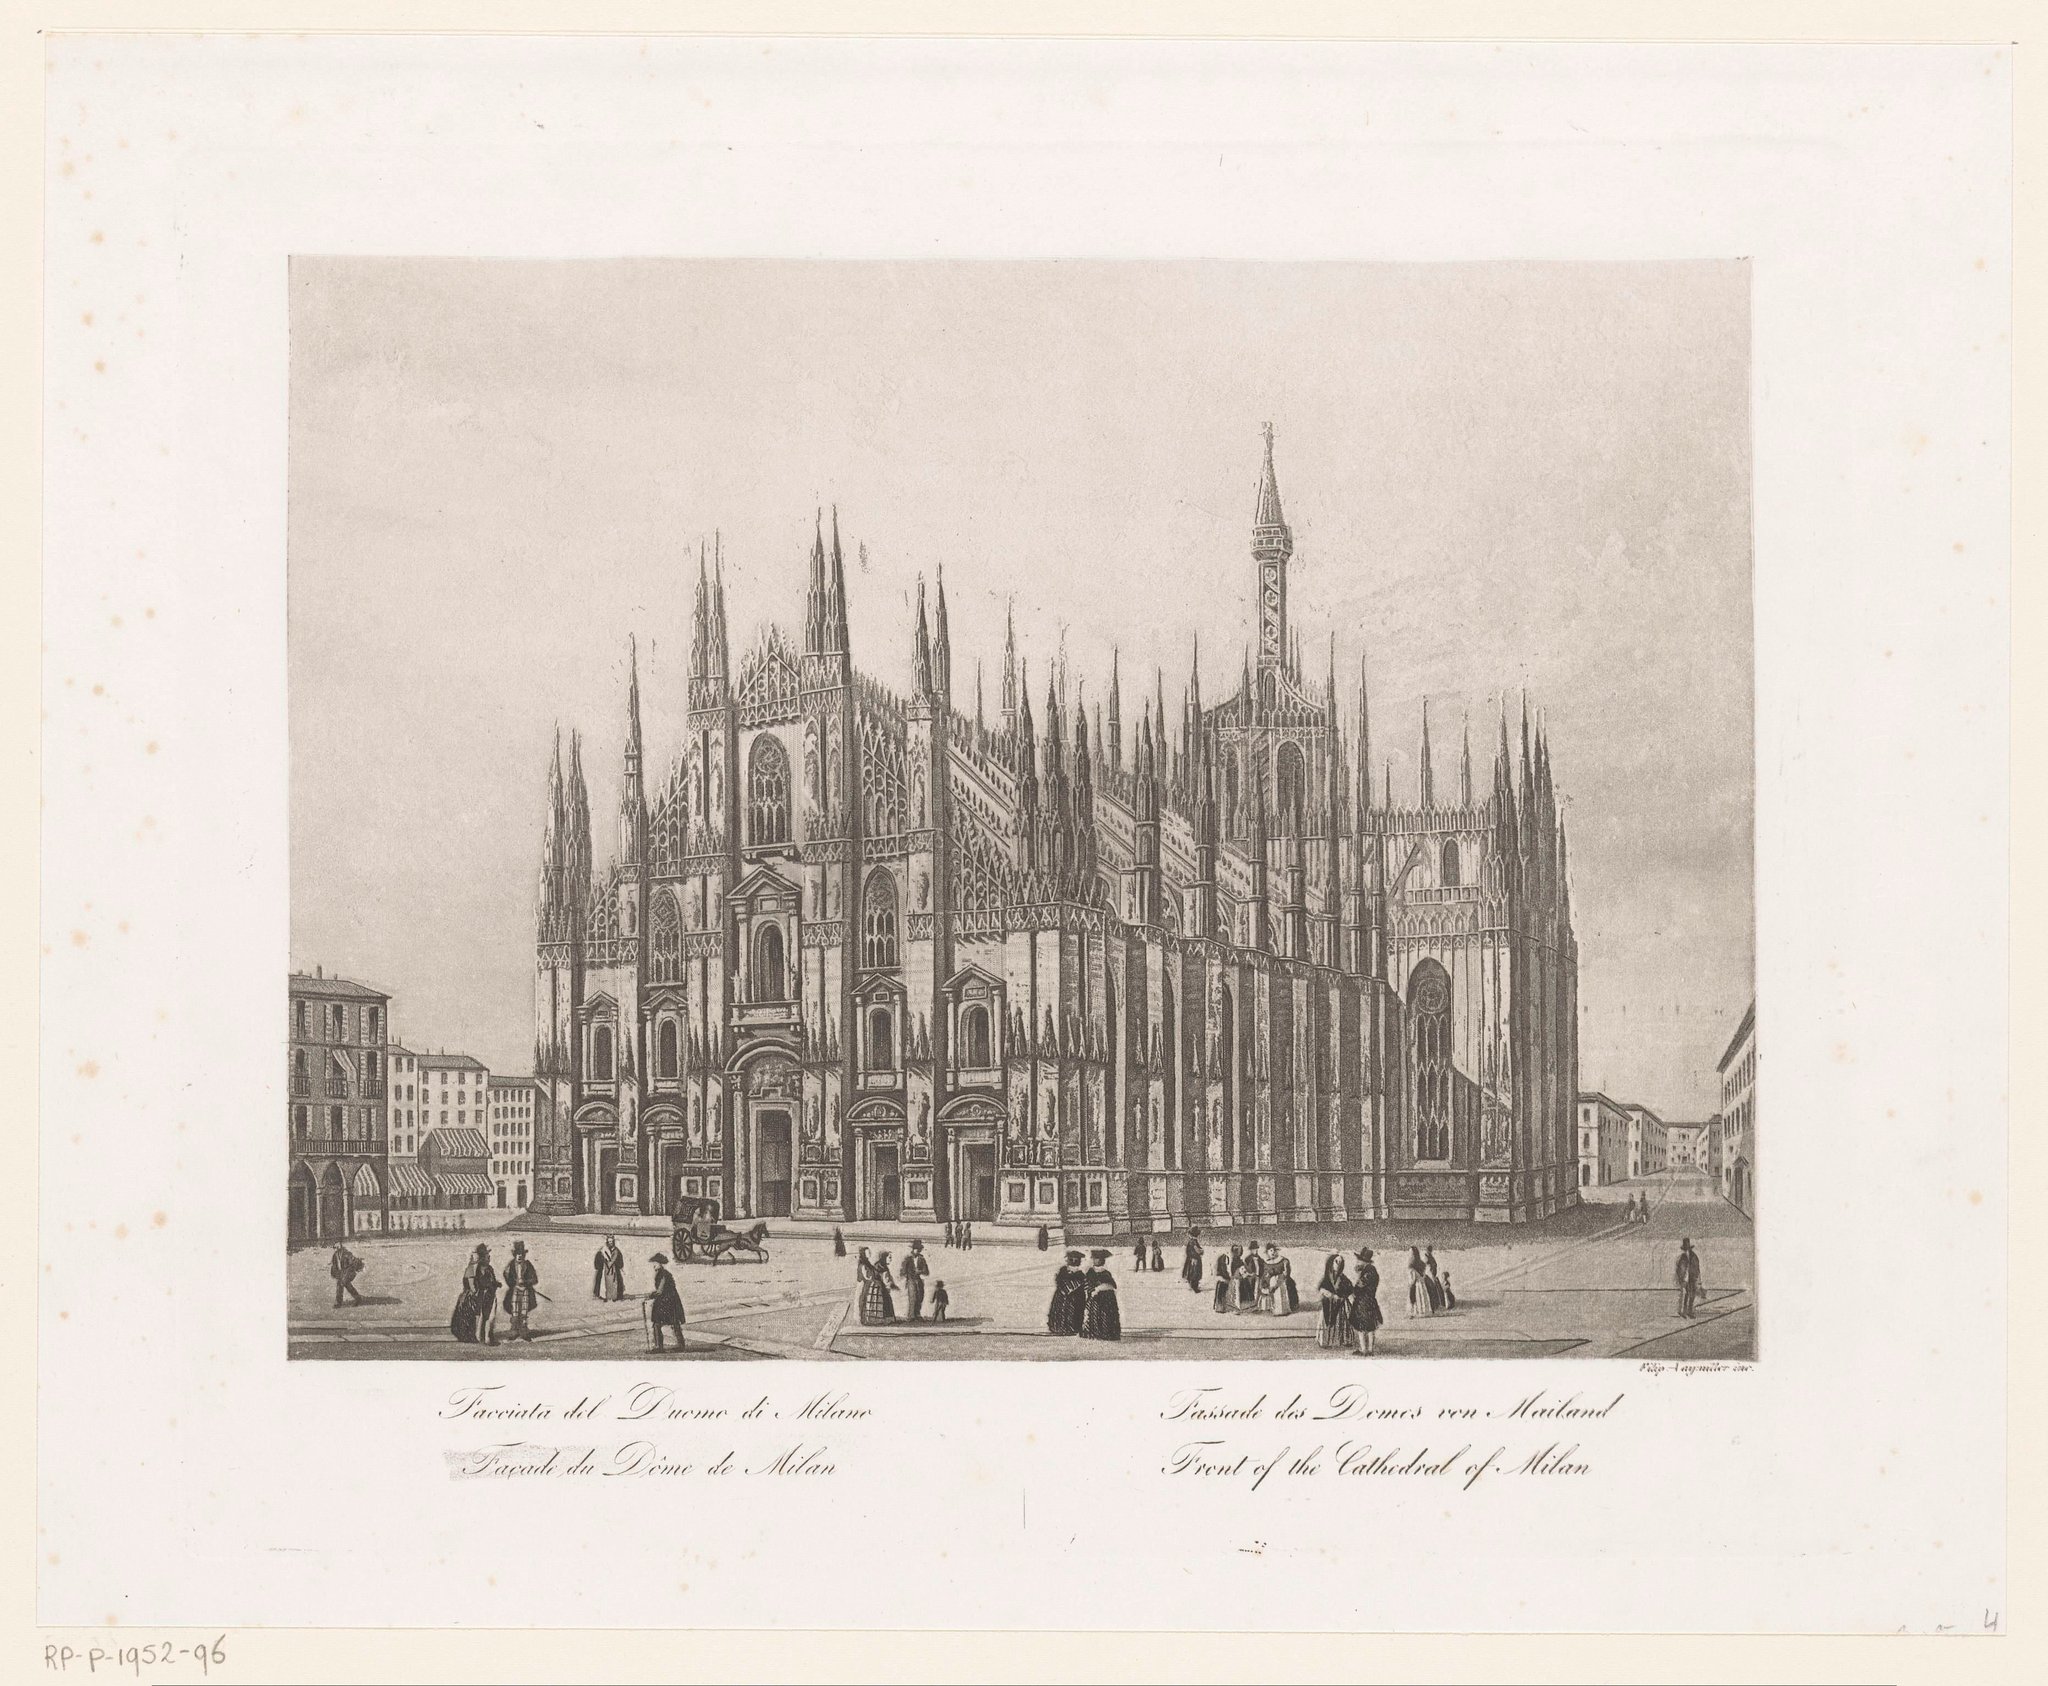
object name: print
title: Gezichten op de Dom van Milaan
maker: filippo naymiller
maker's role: print maker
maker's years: 1804-1863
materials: paper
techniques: aquatint, etching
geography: italy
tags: square, place, circus, etc., church (exterior)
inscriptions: collector's mark: Lugt 2228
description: Piazza del Duomo te Milaan met de Dom van vooraf gezien. Op het plein verscheidene figuren.